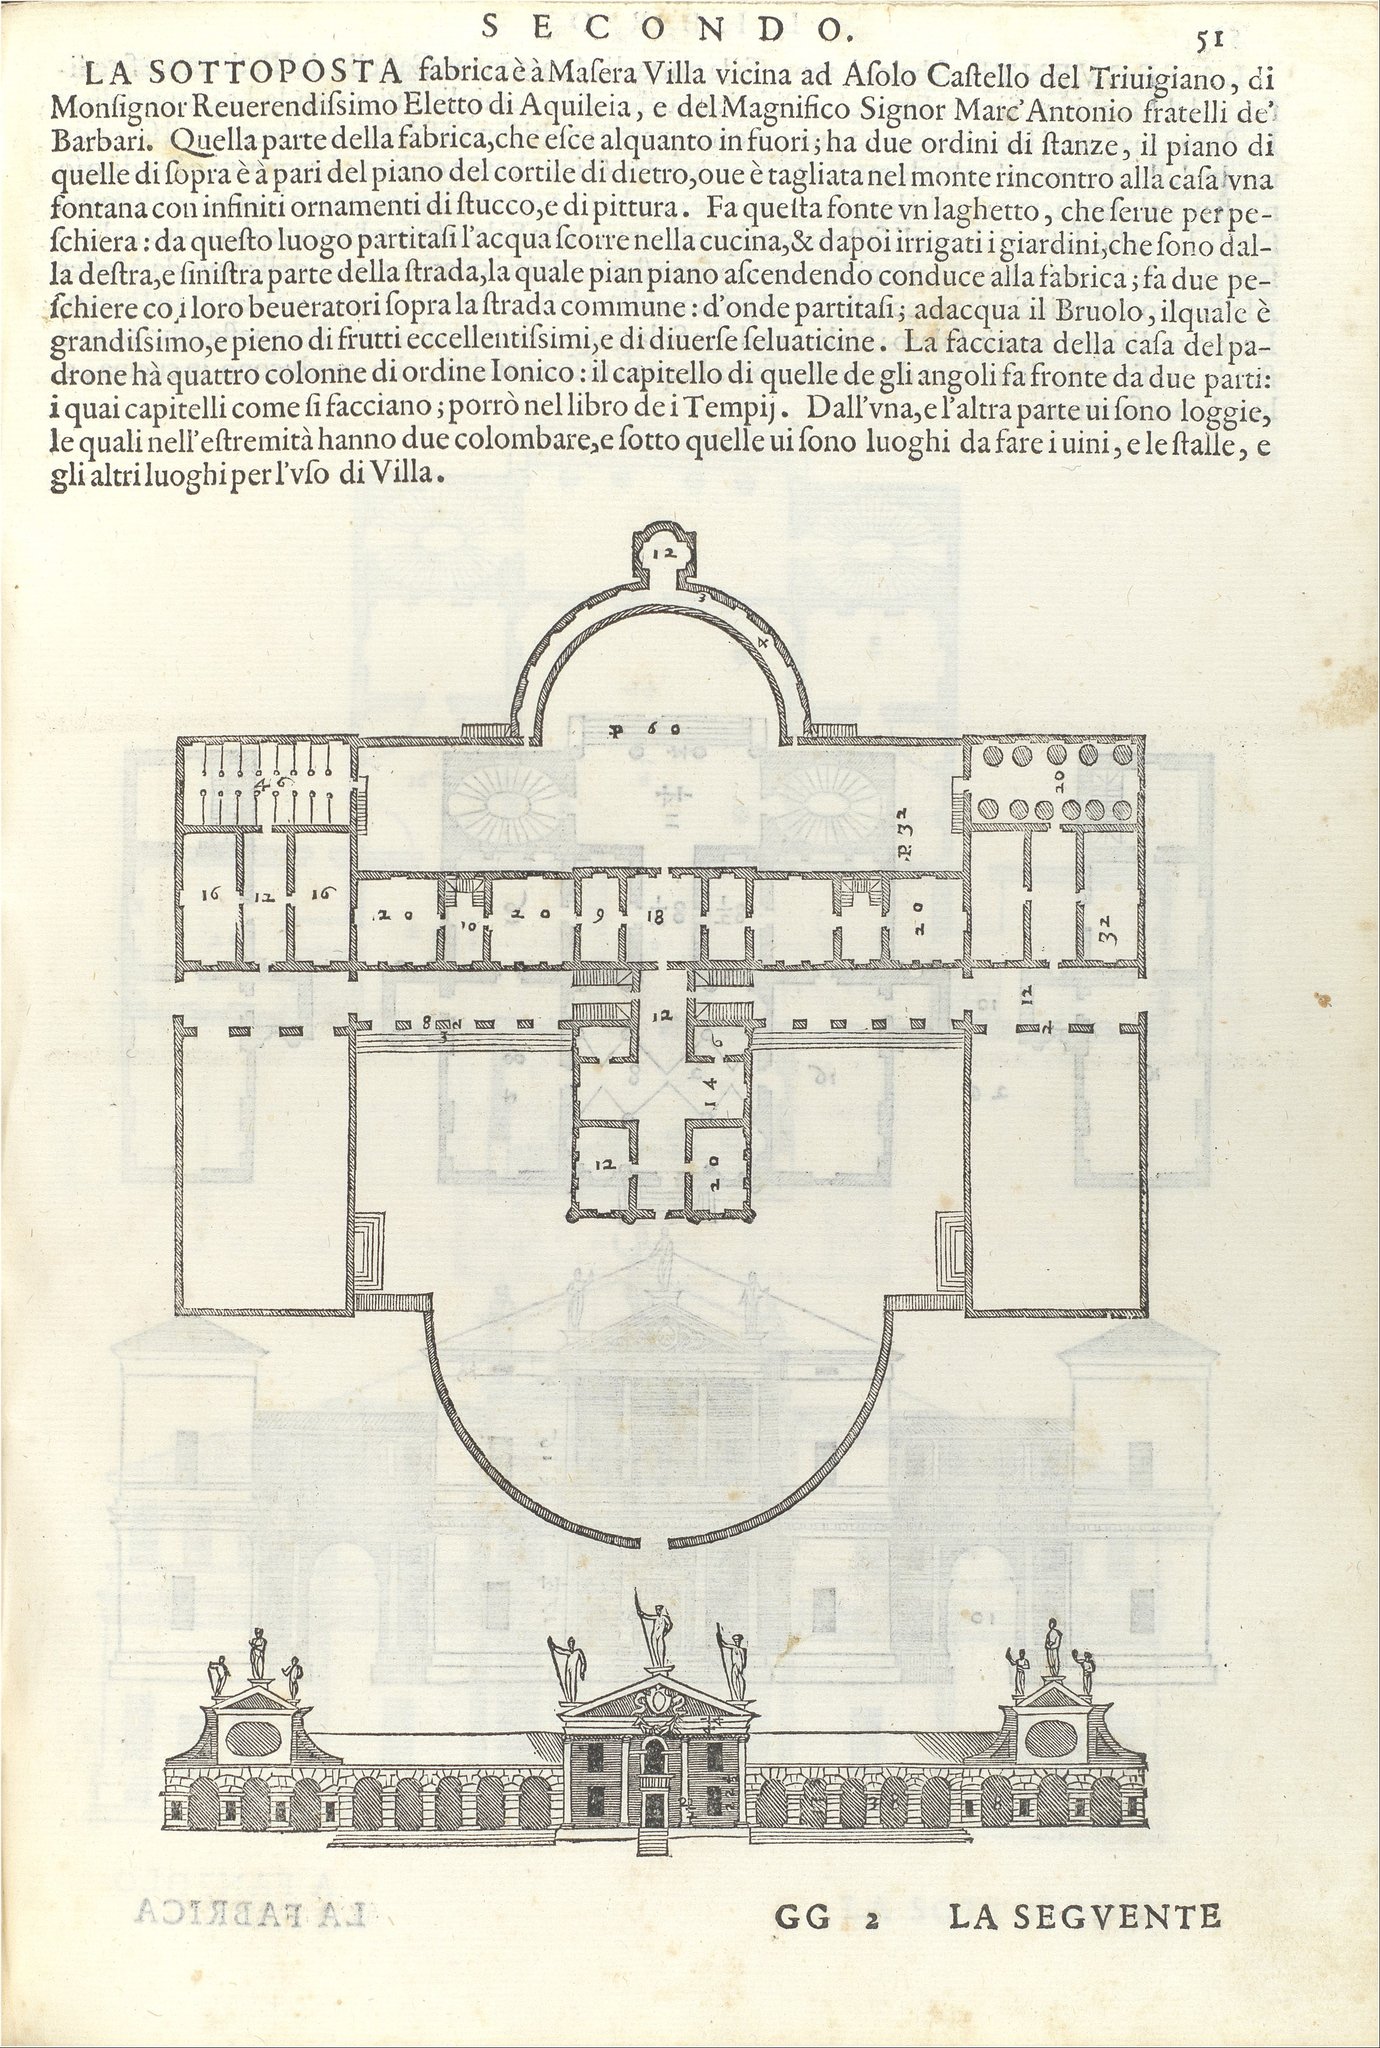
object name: book print ornament architecture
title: Villa Barbaro, from I quattro libri dell'architettura di Andrea Palladio (Book 2, page 51)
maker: andrea palladio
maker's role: author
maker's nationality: italian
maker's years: 1508-1580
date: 1570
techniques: printing, woodcut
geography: italy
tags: architecture